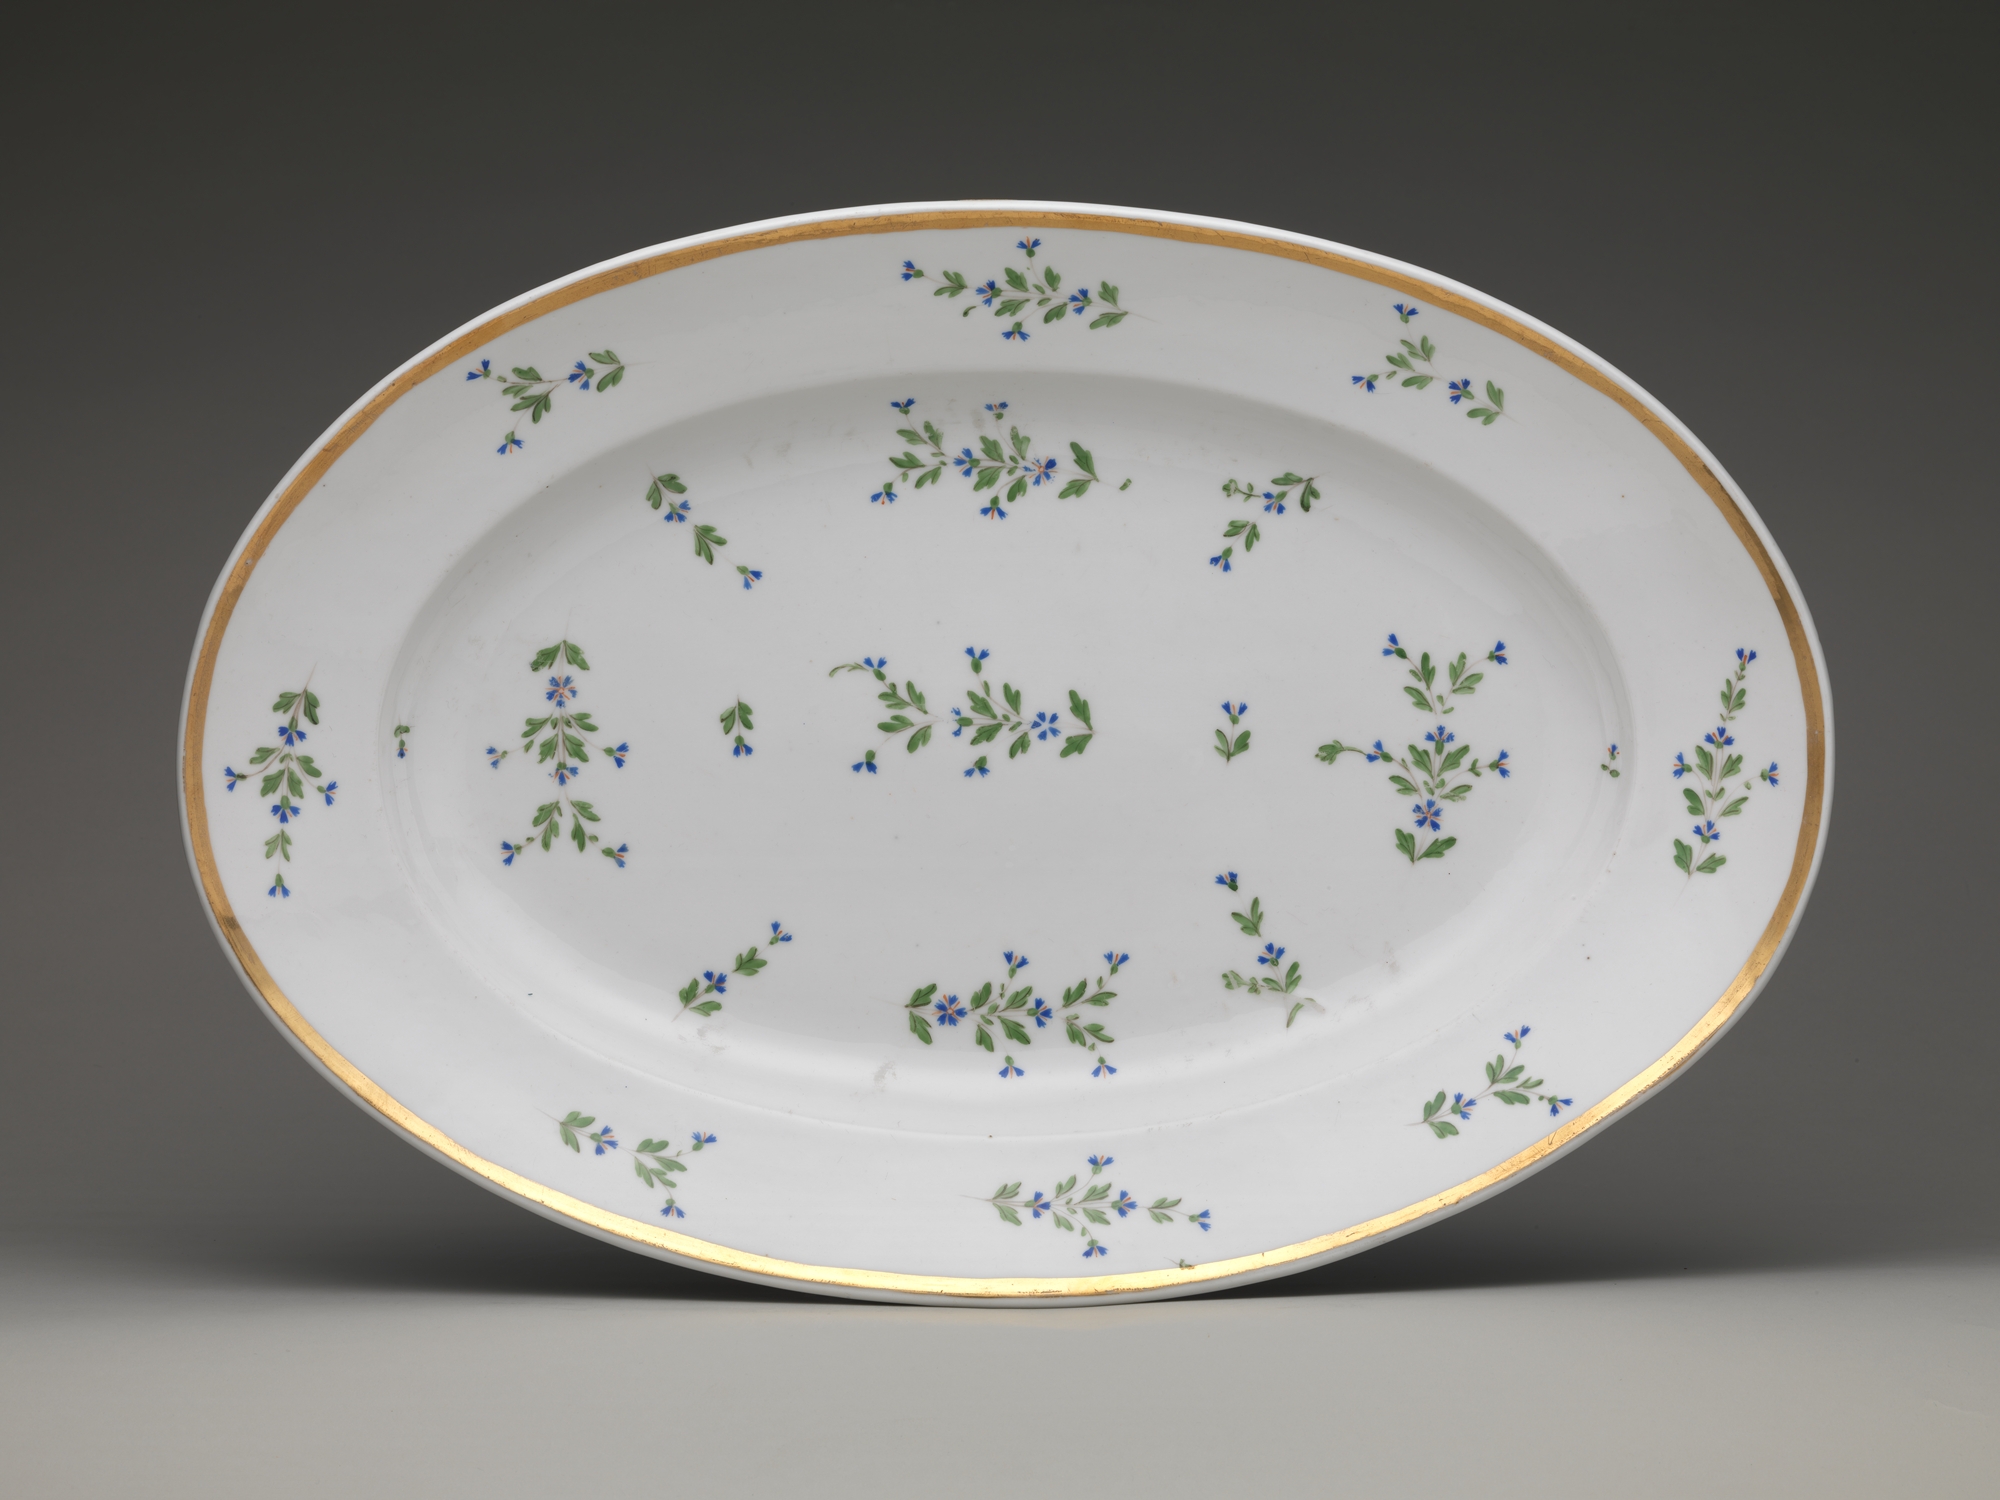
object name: platter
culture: french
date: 1815-1830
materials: porcelain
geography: france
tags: flowers